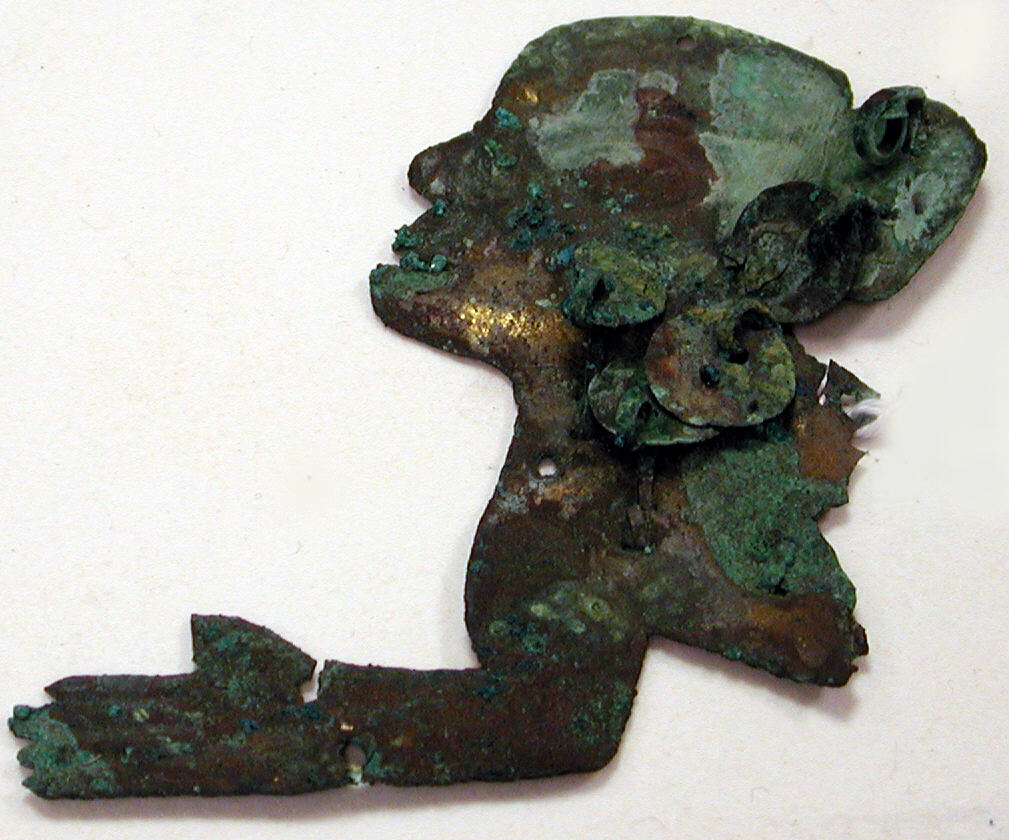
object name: ornament fragment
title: Figure Fragment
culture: moche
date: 501-700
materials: metal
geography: peru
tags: hands,heads